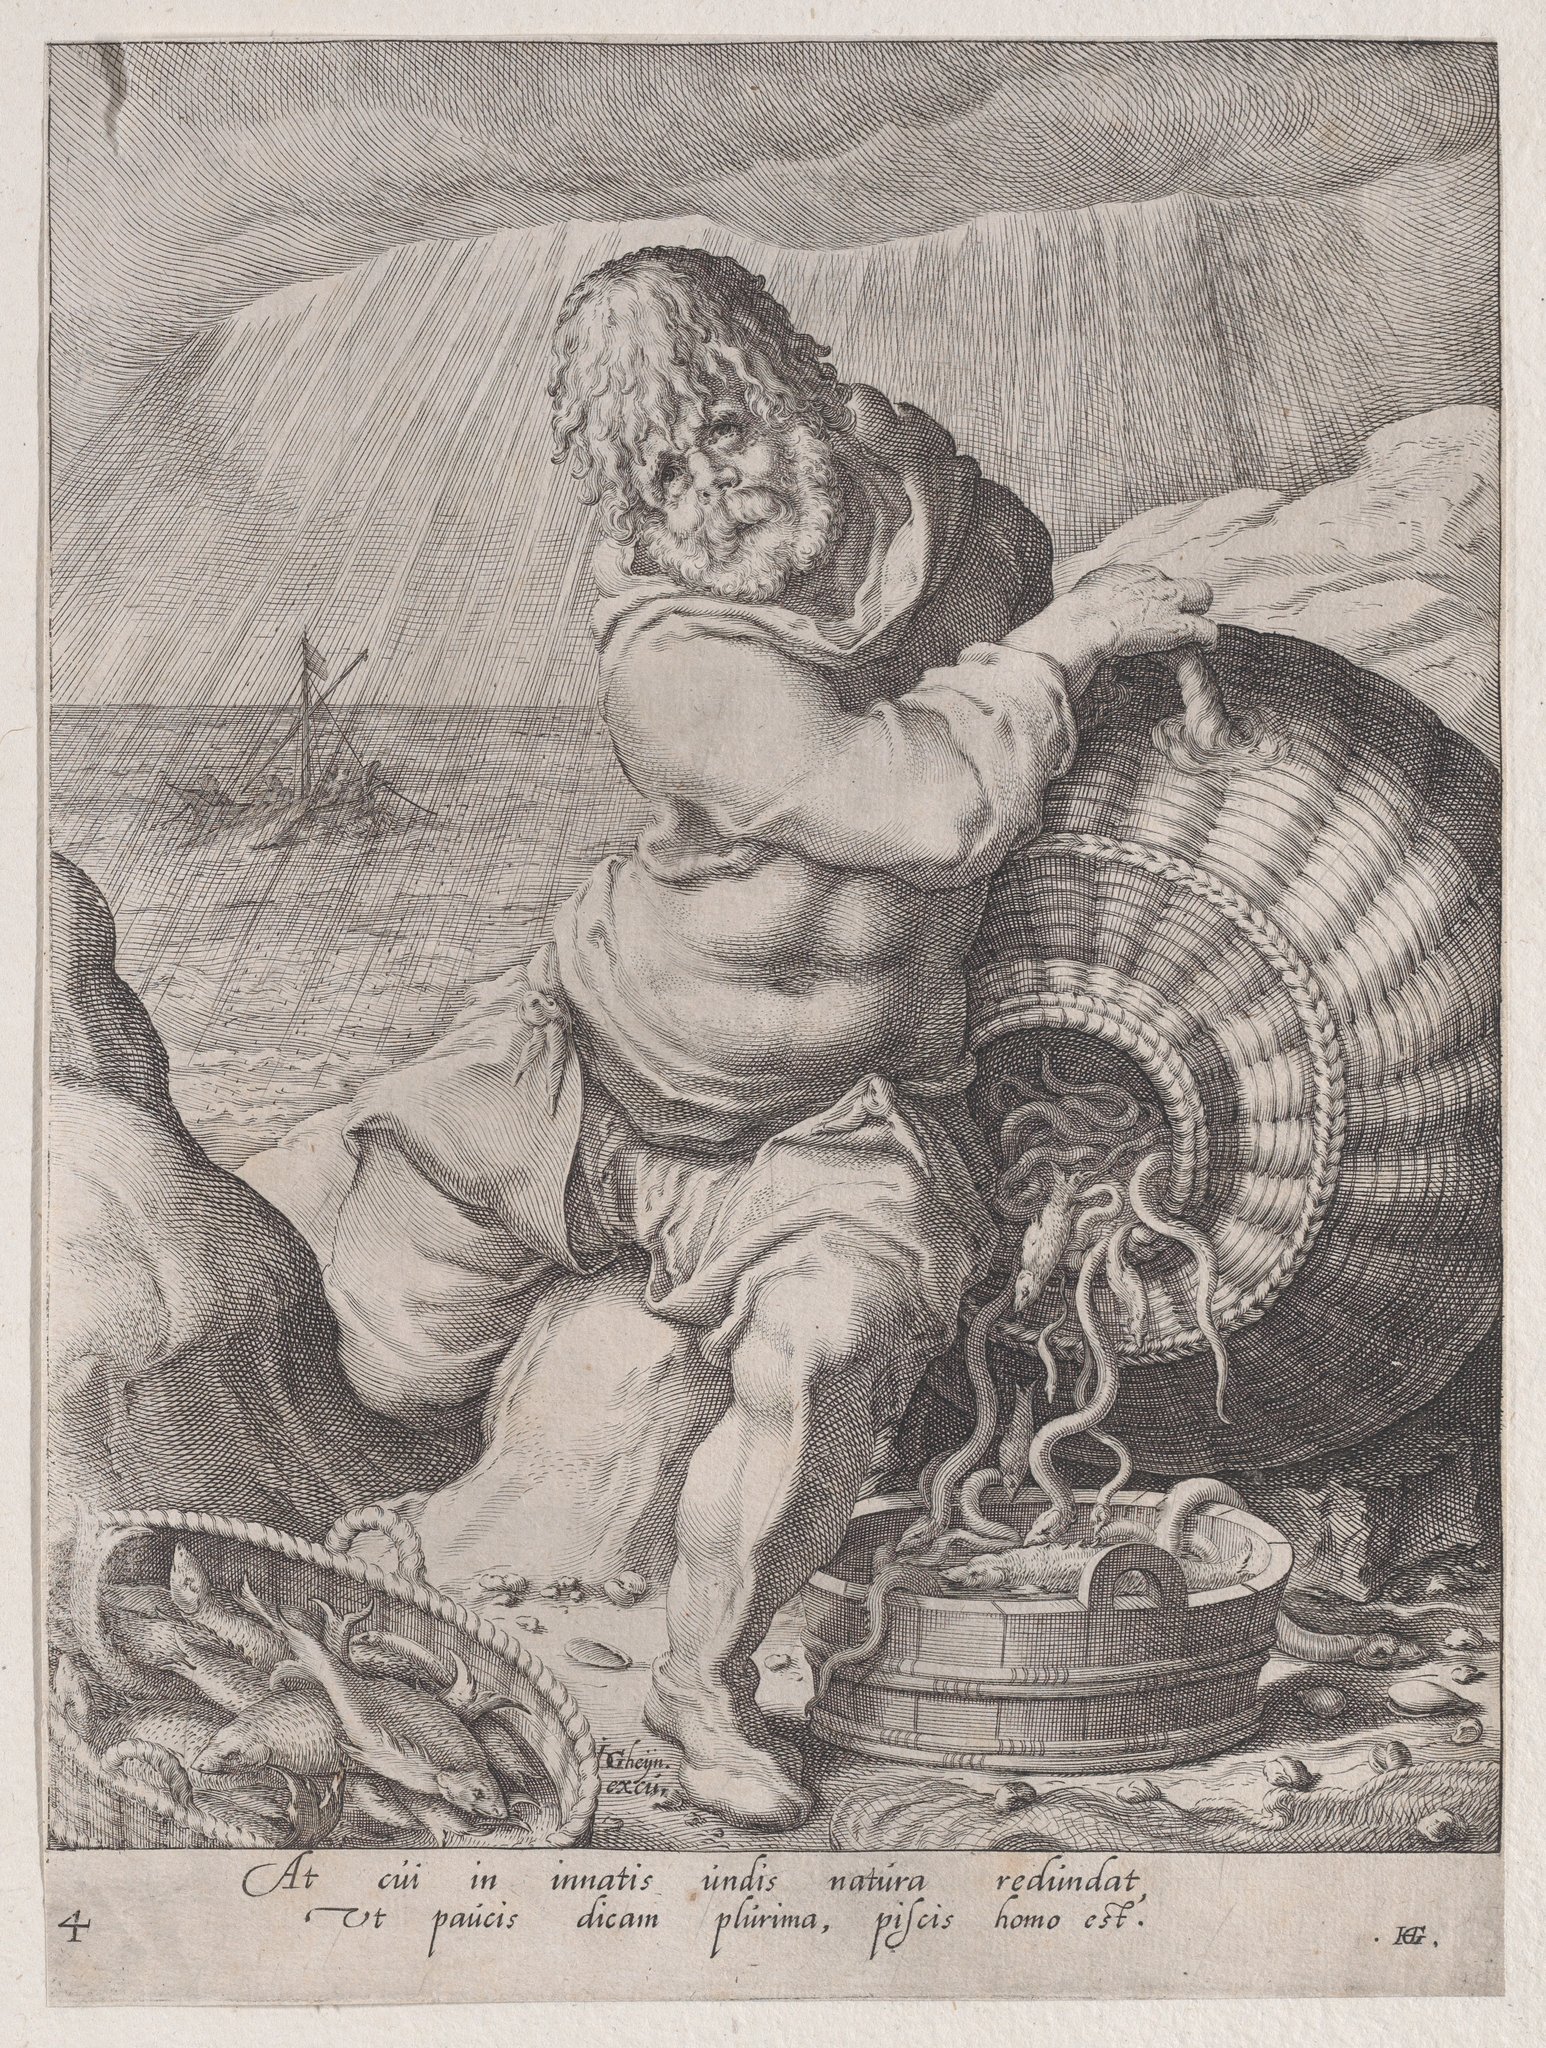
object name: print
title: Water (Phlegmaticus), from "The Four Temperaments"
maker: jacques de gheyn (ii)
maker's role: artist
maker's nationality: netherlandish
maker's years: 1565-1629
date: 1596-1597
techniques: engraving